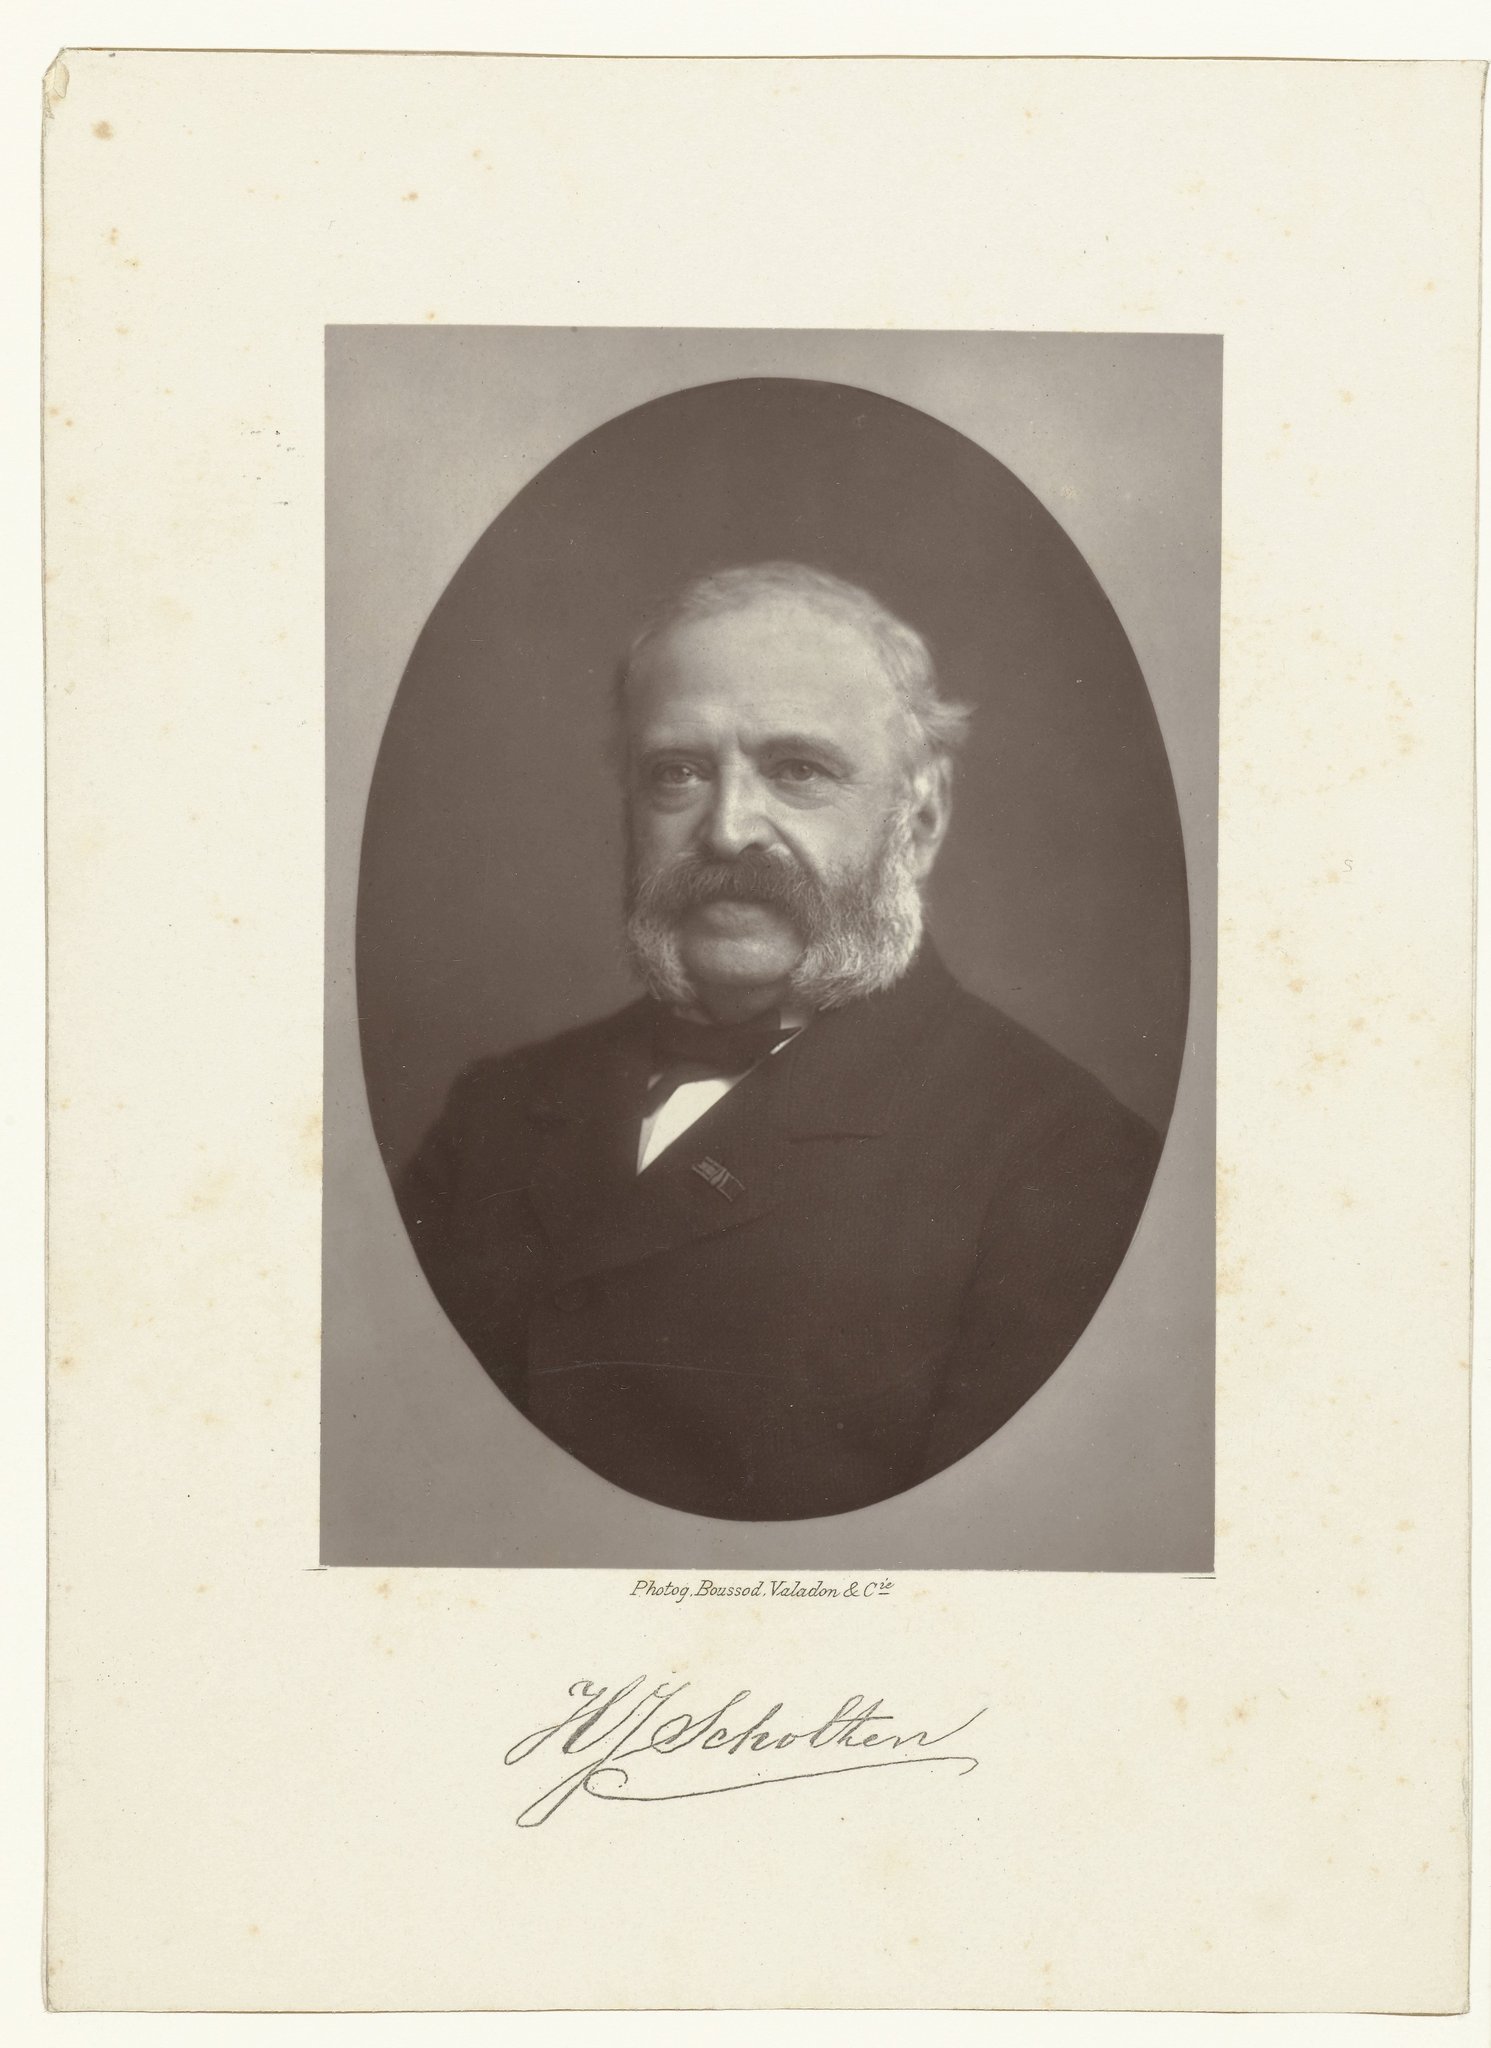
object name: photograph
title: H.J. Scholten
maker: maurits verveer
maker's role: painter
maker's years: 1817-1903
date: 1881-1885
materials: cardboard, paper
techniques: woodburytype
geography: the hague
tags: amsterdam, painter, print maker, draughtsman, hendrik jacobus scholten, portrait, self-portrait of painter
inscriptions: annotation: ‘H.J. Scholten’